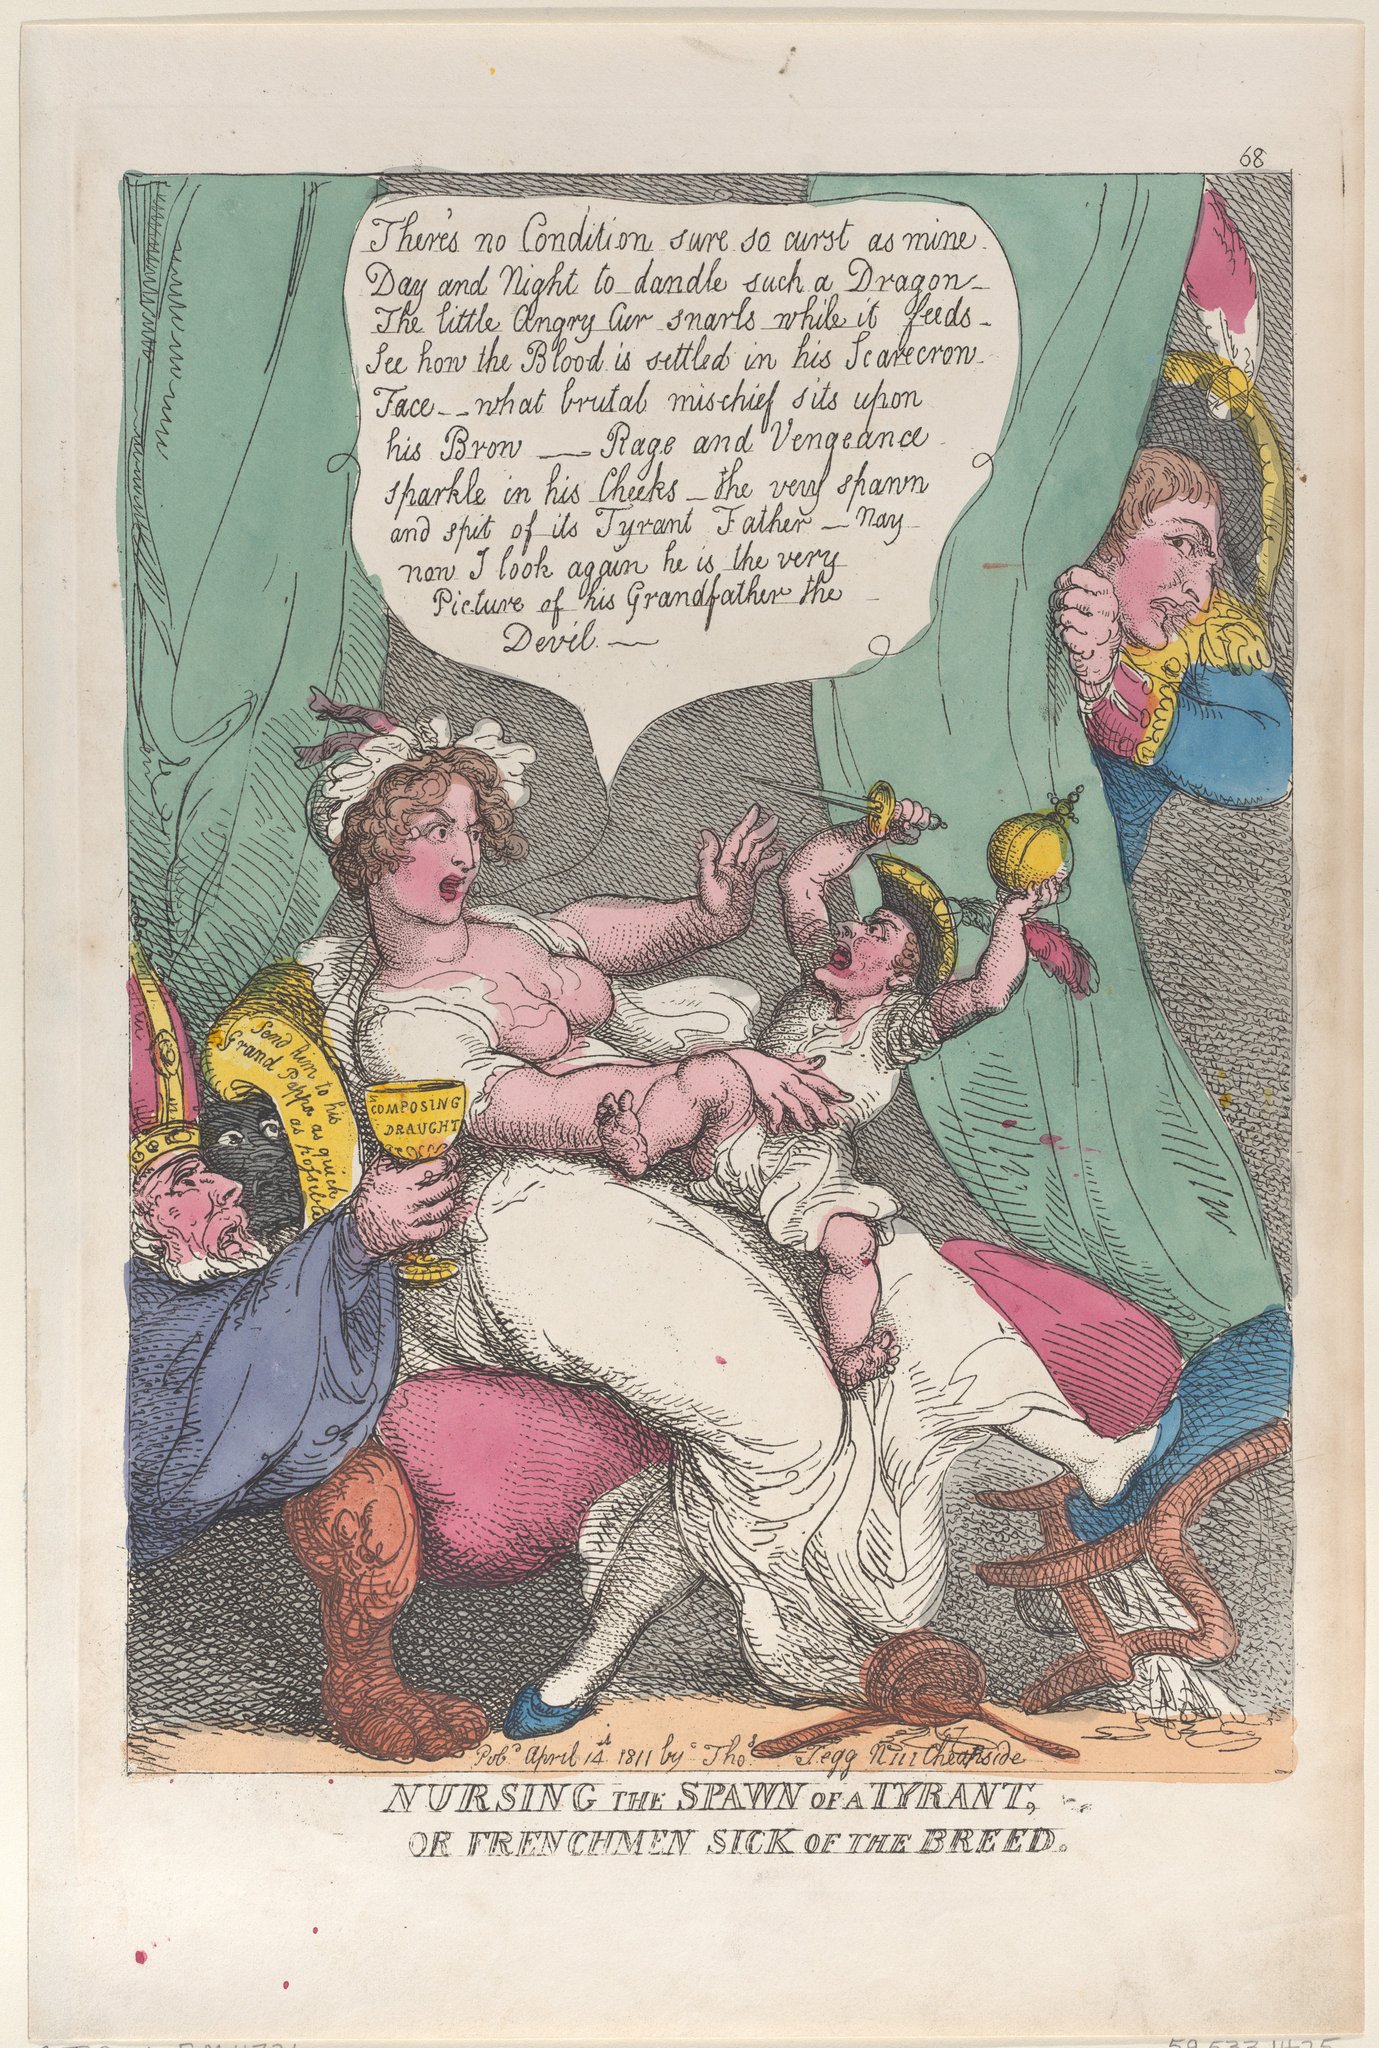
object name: print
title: Nursing the Spawn of a Tyrant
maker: thomas rowlandson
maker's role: artist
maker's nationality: british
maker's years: 1757-1827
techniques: etching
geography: london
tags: satire,napoleon i,women,politics